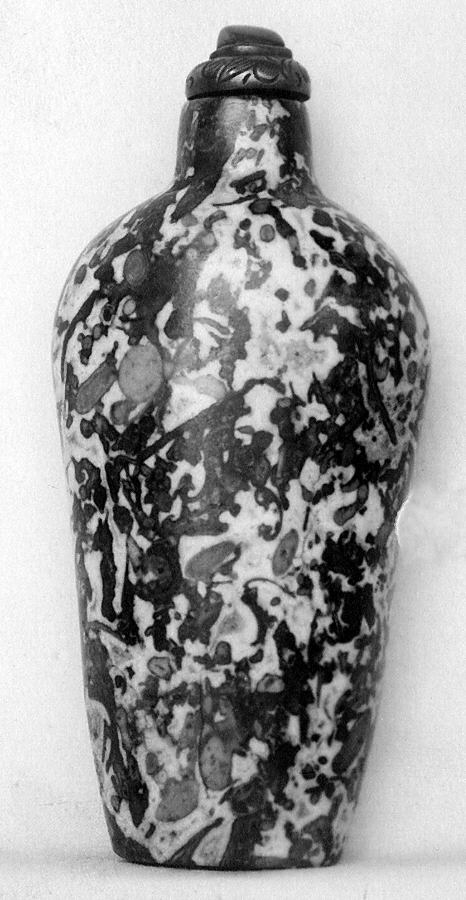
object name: snuff bottle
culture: chinese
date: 1736-1795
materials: stone